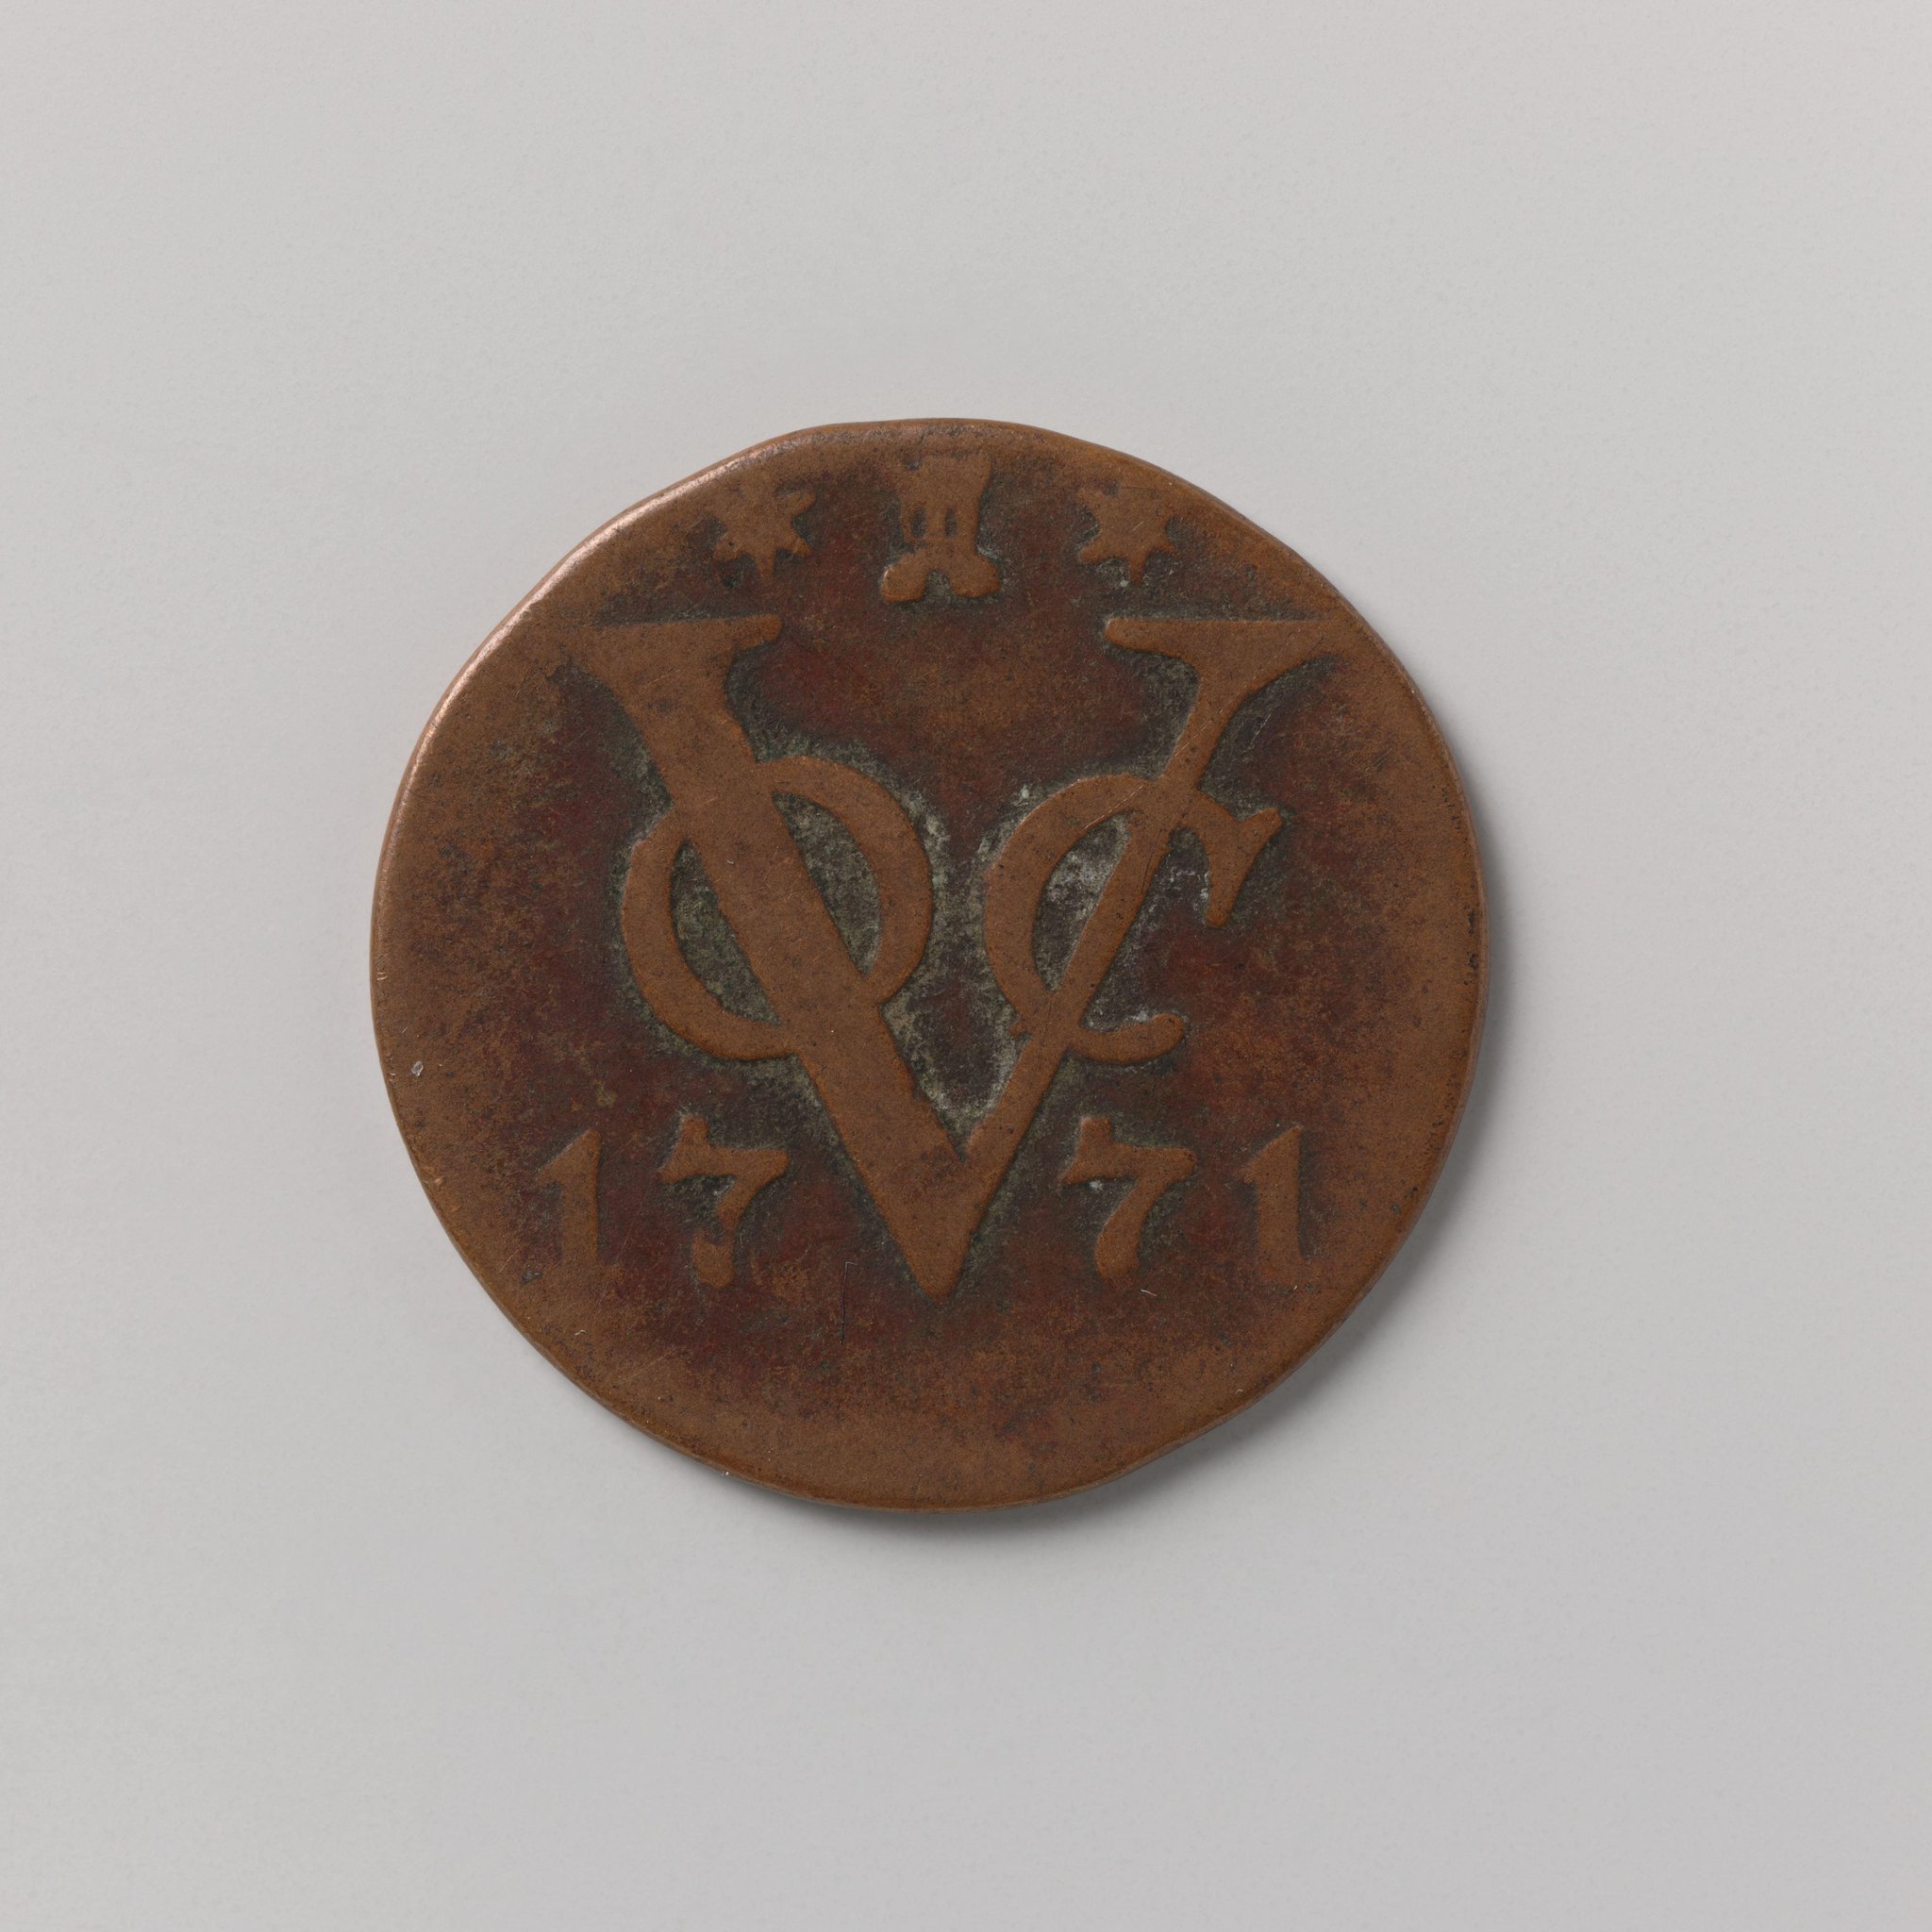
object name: coin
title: VOC, duit Zeeland, 1771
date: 1771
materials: copper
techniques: striking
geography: middelburg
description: Koperen munt. Voorzijde: gekroond wapenschild van Zeeland. Keerzijde: monogram van de VOC, waarboven muntteken en waaronder jaartal. Gladde rand.